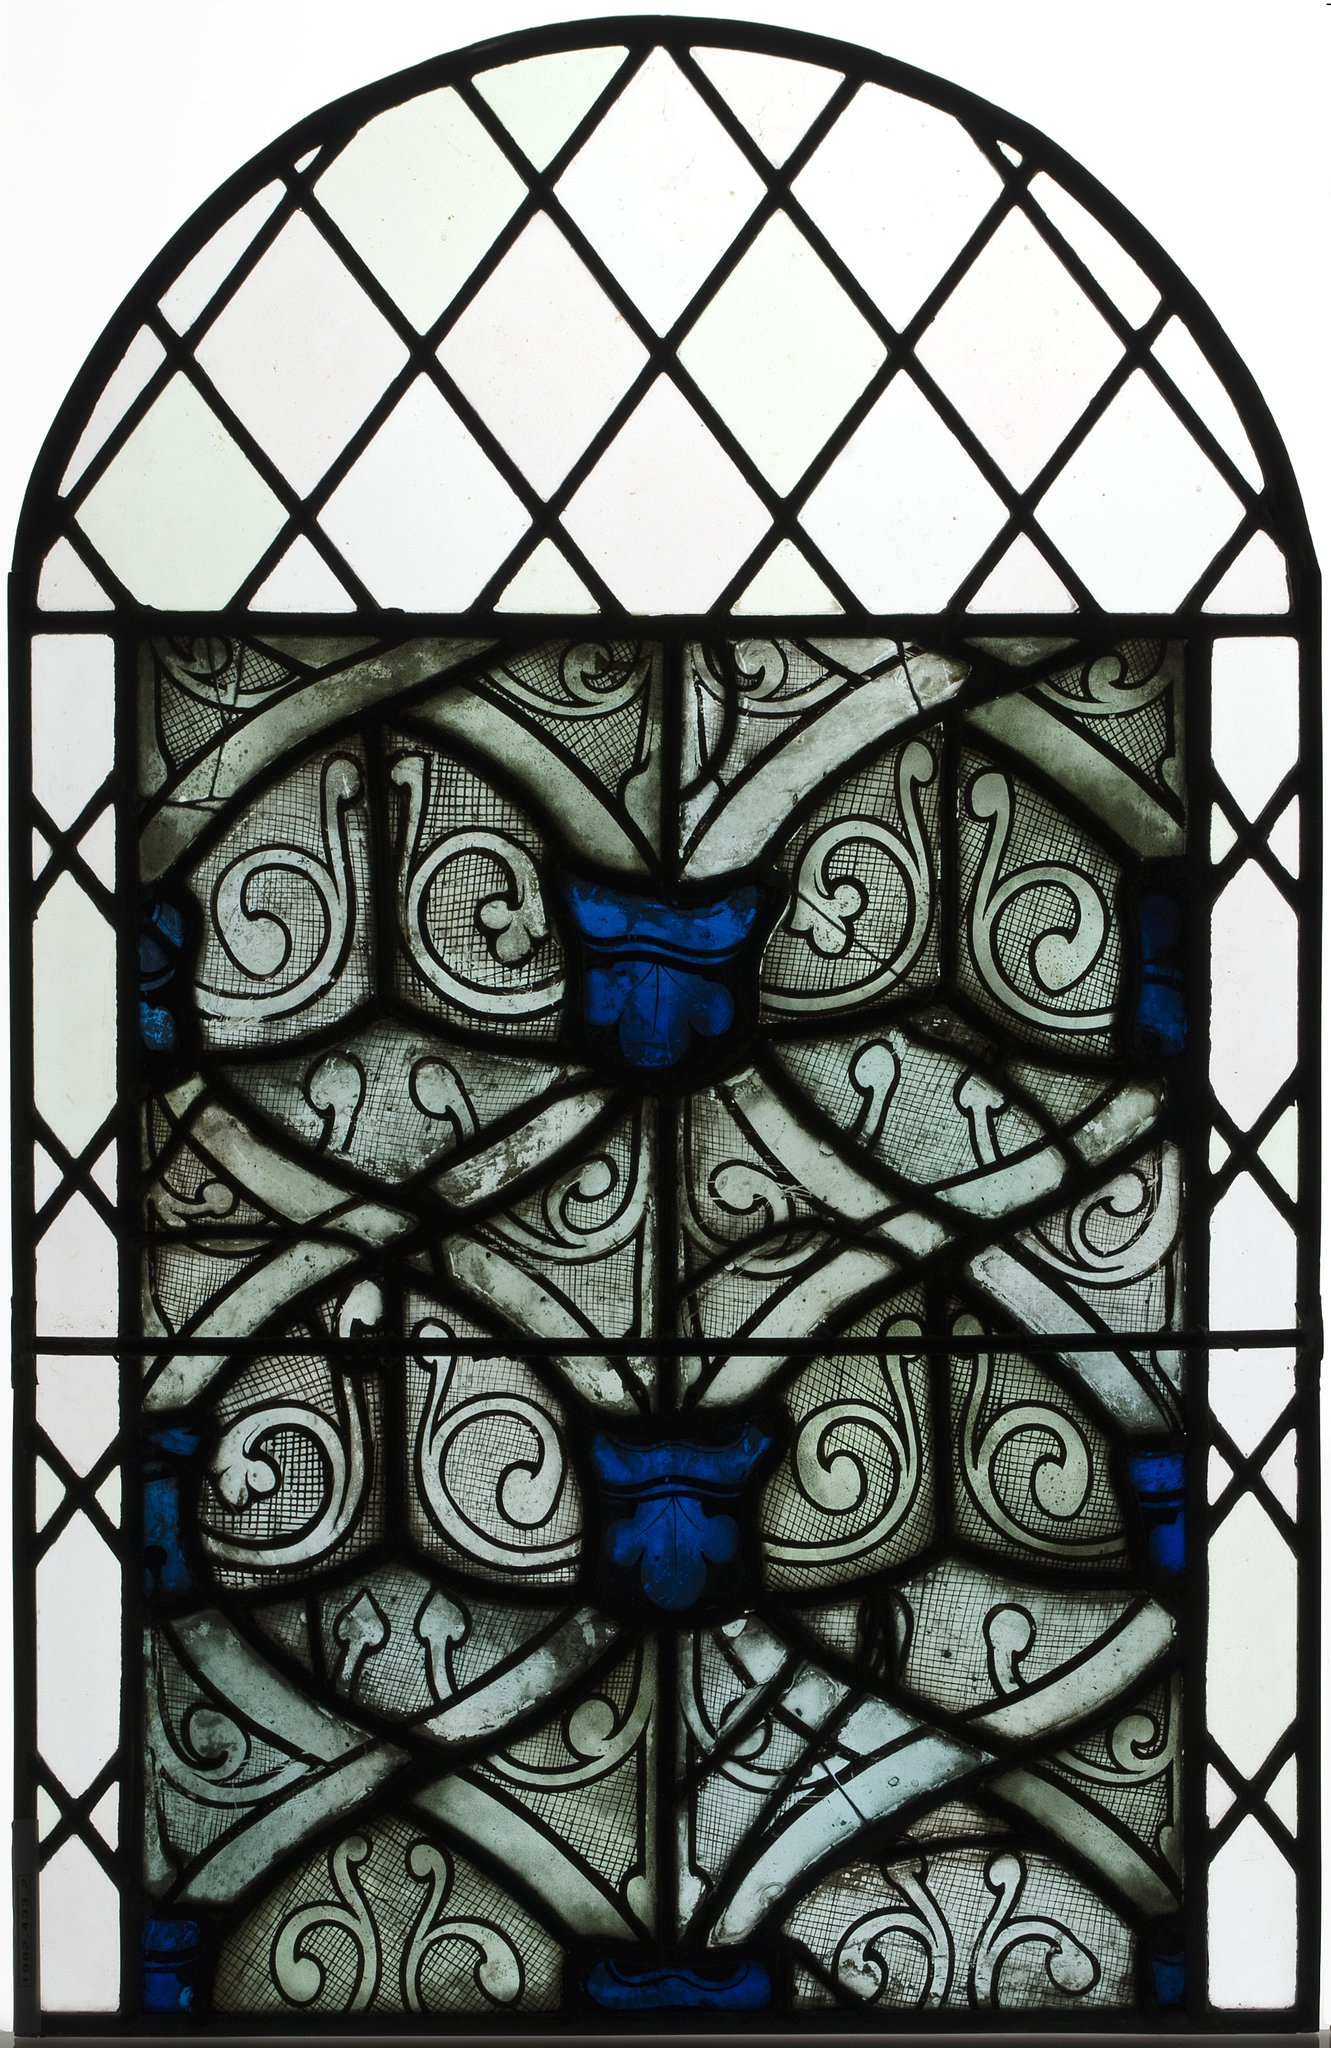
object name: panel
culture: french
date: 1260-1270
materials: glass, metal, paint